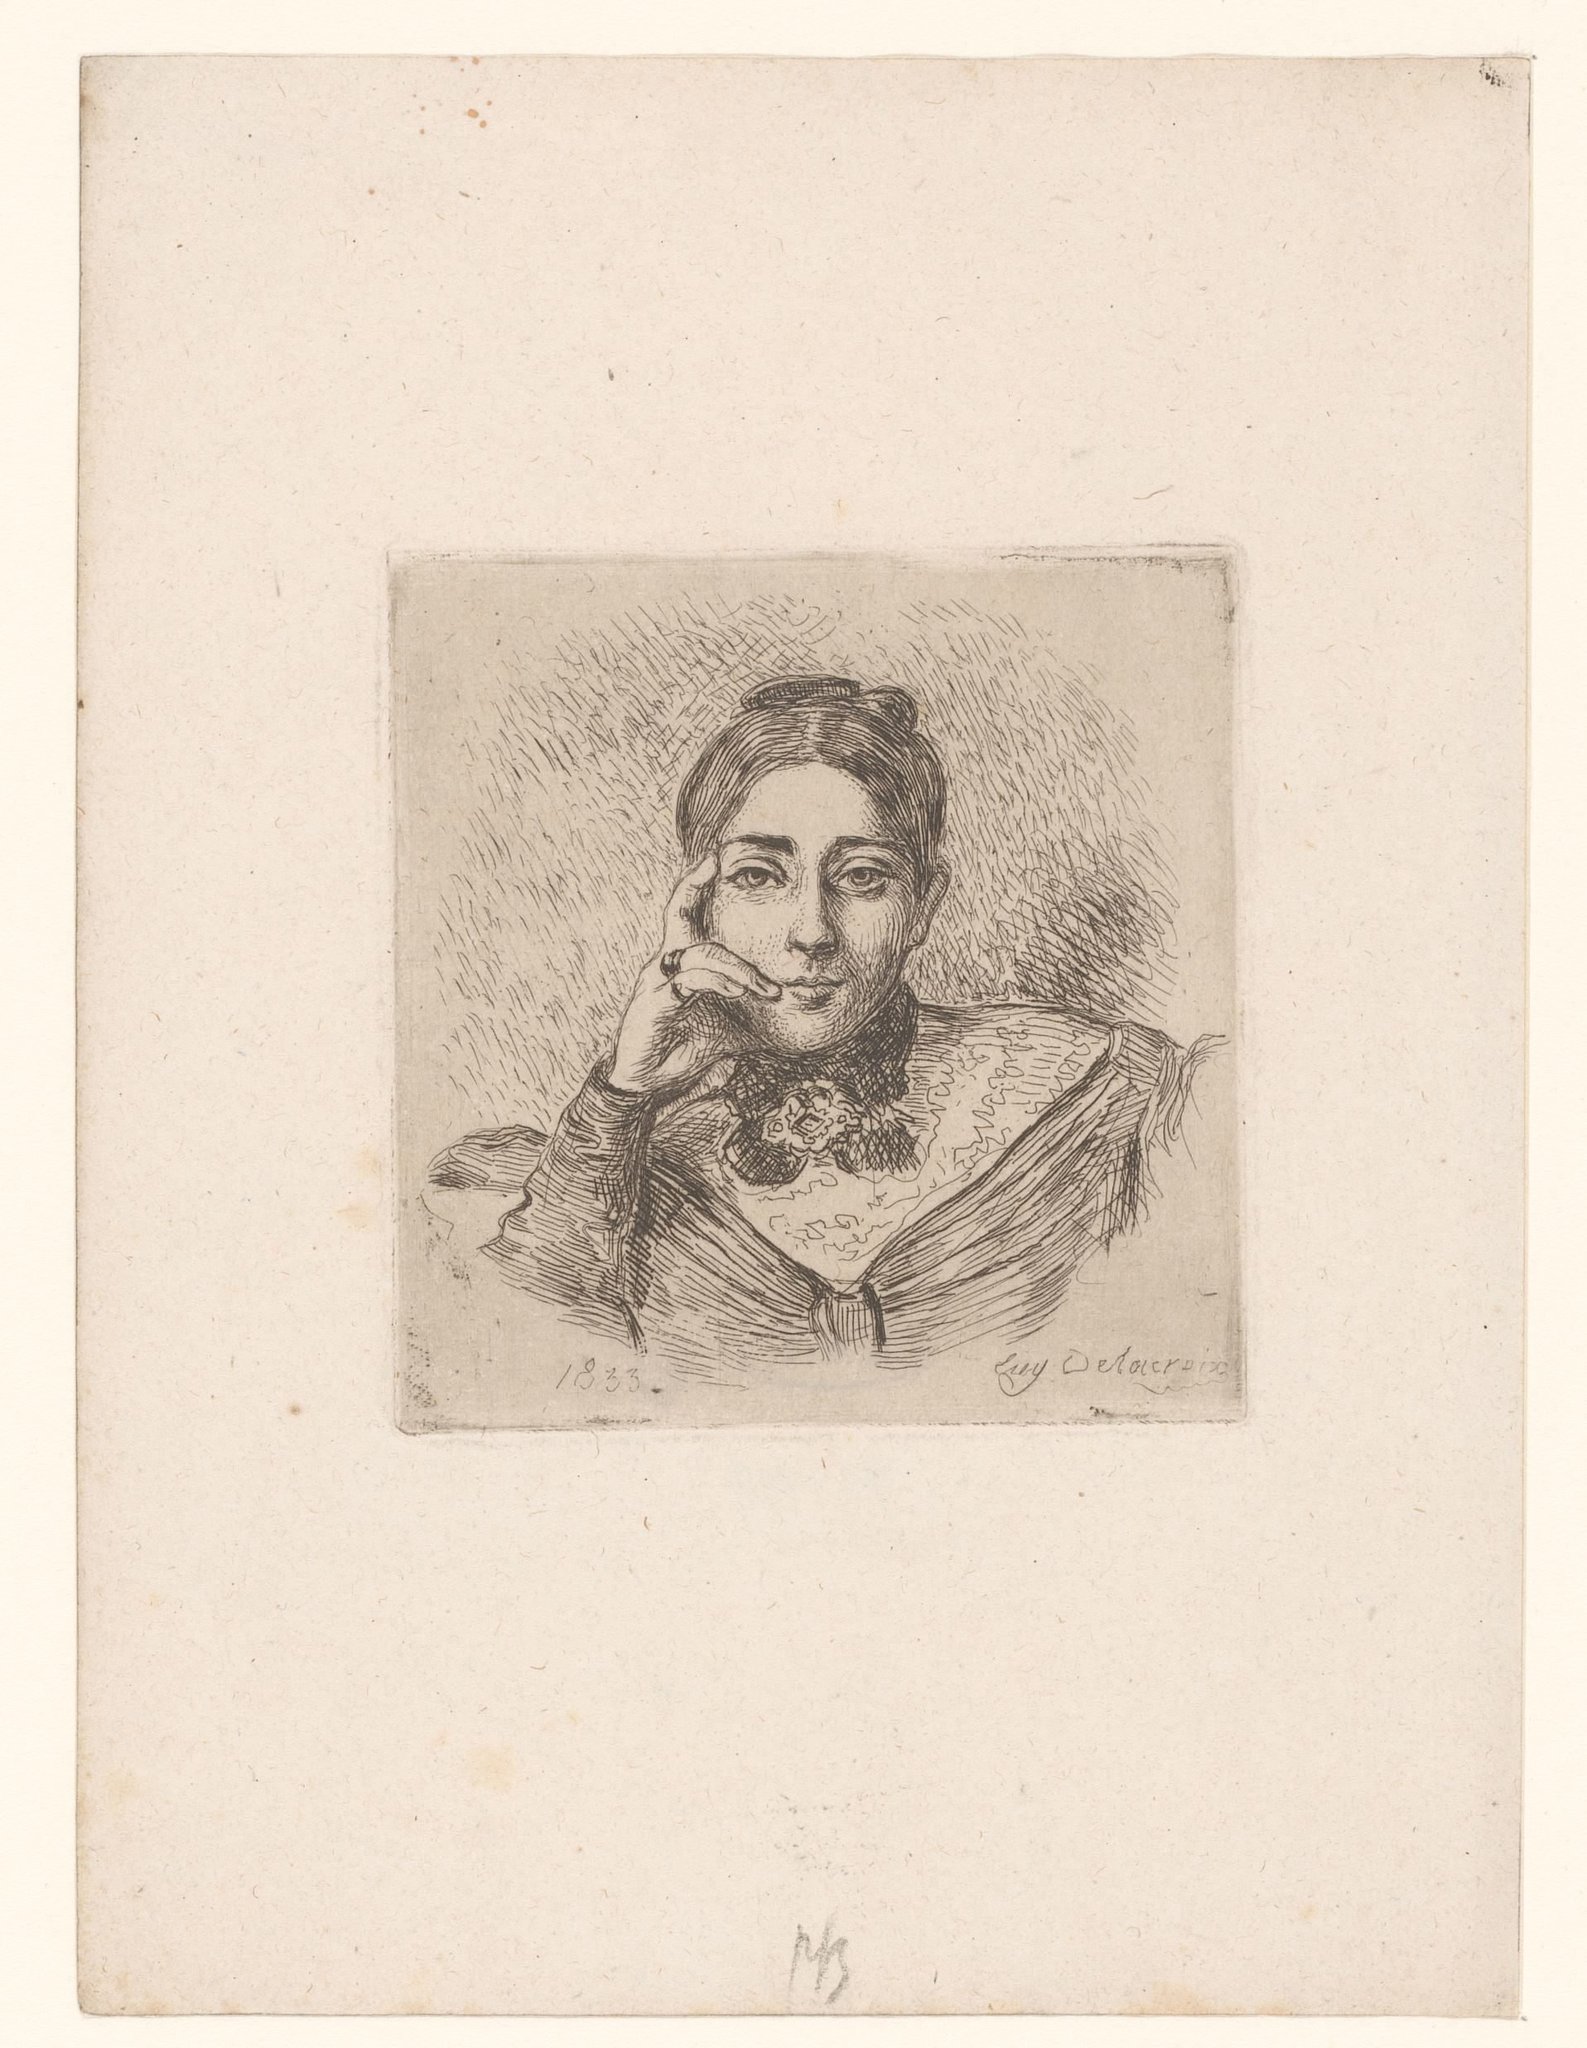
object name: print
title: Portret van Madame Fréderic Villot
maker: eugène delacroix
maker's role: draughtsman, print maker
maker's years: 1798-1863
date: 1833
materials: paper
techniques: etching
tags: historical persons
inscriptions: collector's mark: Lugt 2228, collector's mark: Lugt 2760